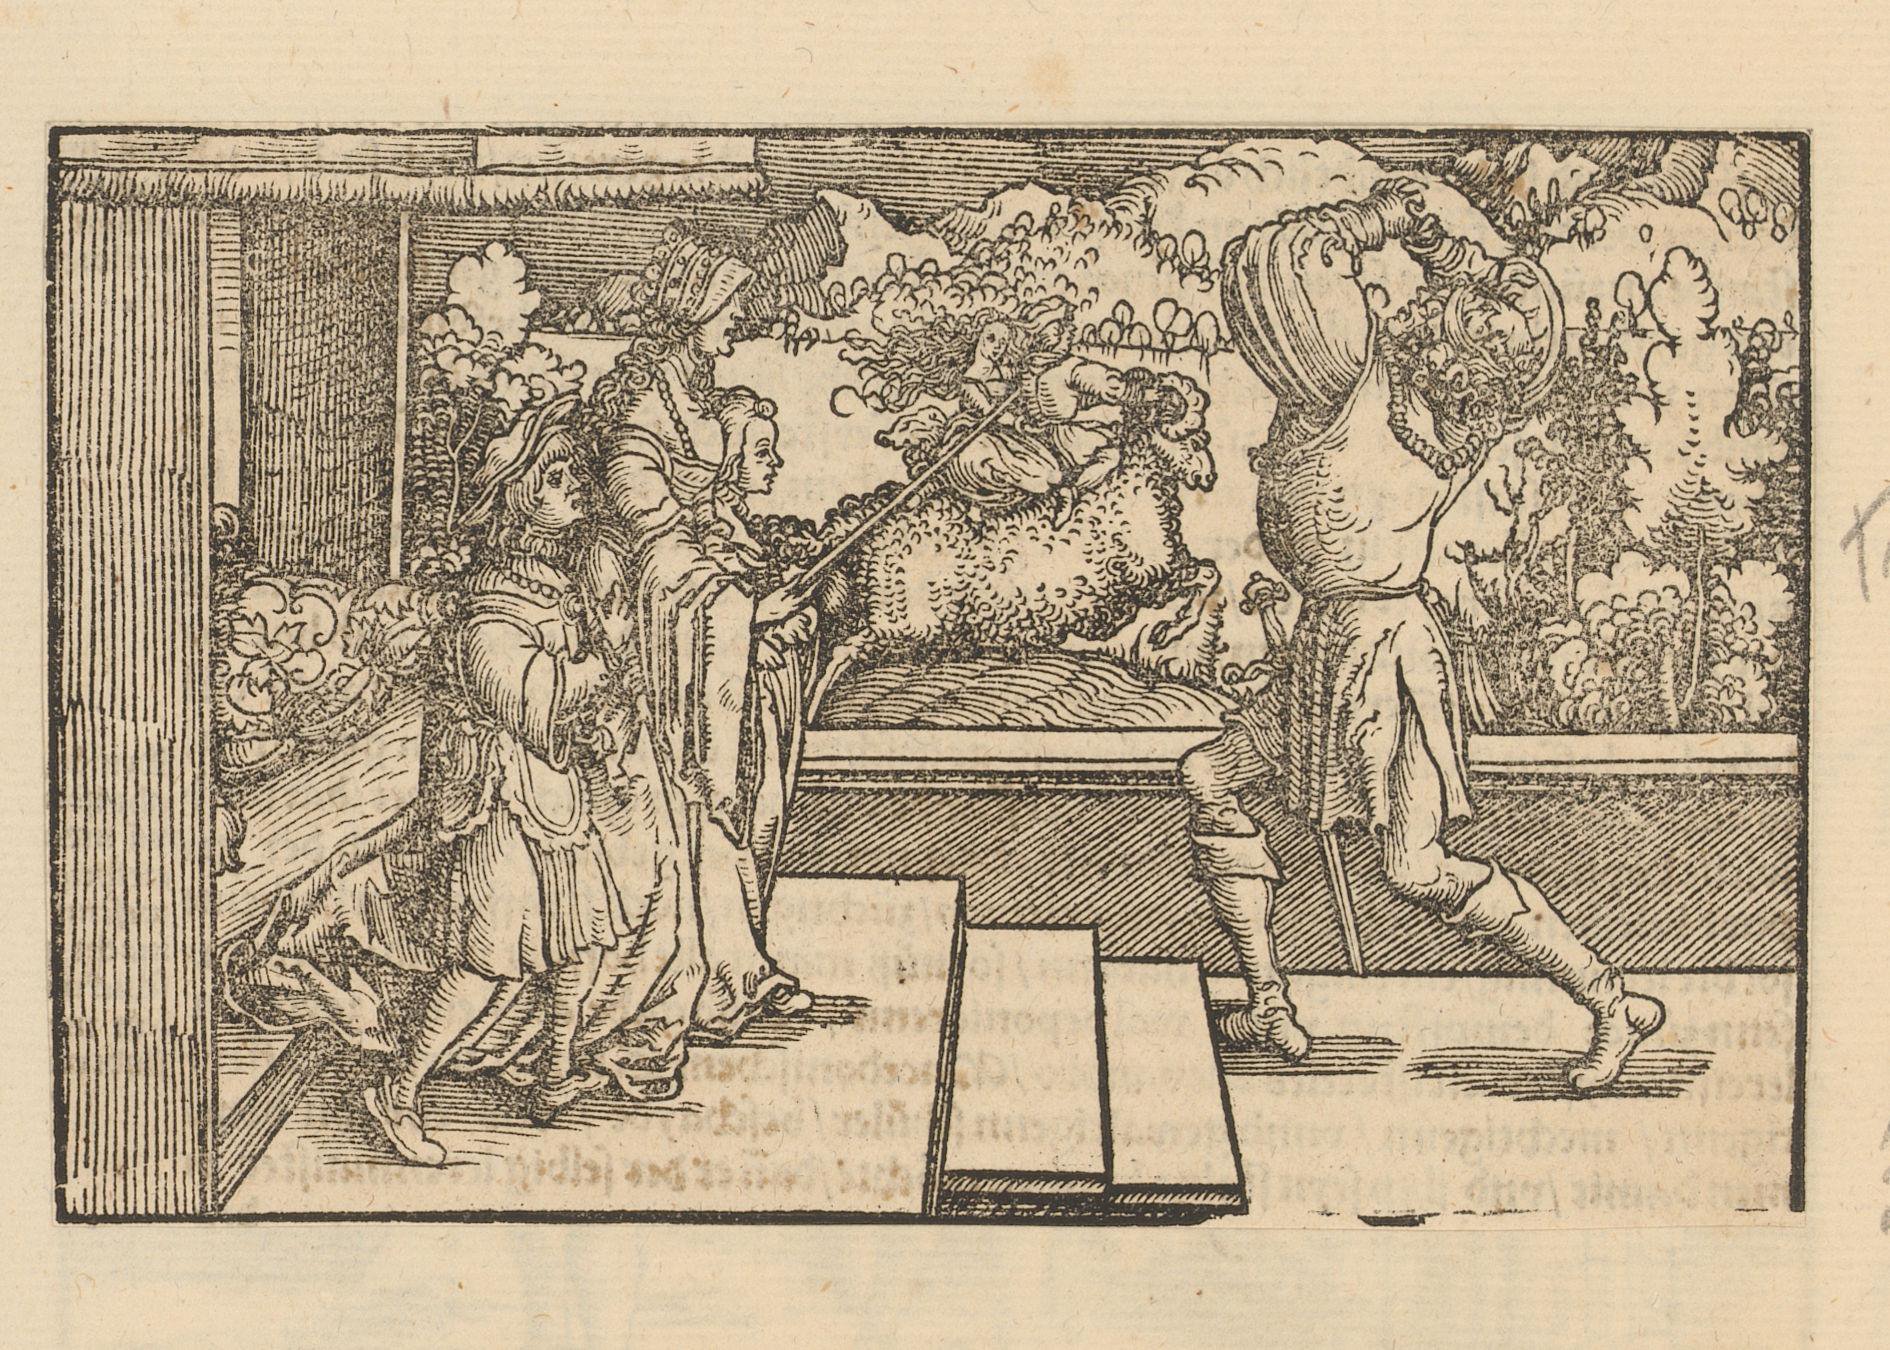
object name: print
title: Man smeekt voor vergiffenis bij een vrouw met twee kinderen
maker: Anonymous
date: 1514-1532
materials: paper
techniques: letterpress printing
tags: plea, defence, return of runaway child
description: Deze prent is gebruikt in: Petrarca, Francesco. Von der Artzney bayder Glück, des guten und widerwertigen: unnd weß sich ain yeder inn Gelück und Unglück halten sol (...). Augsburg: Heinrich Steiner, 1532. Deze uitgave is ook bekend onder de titel 'Trostspiegel in Glück und Unglück'.